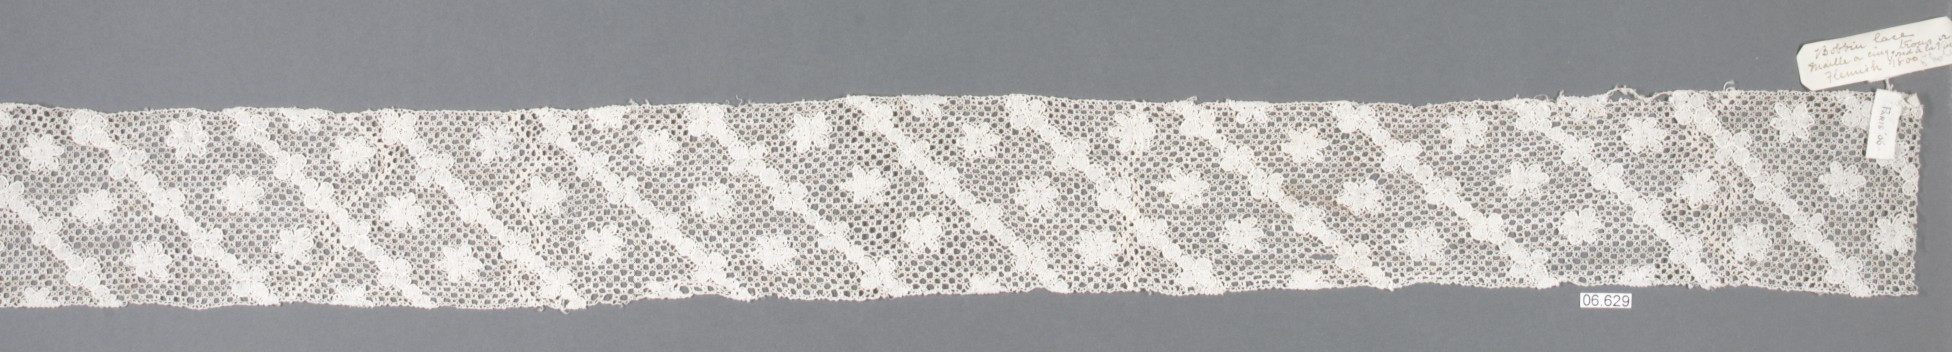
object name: insertion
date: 1800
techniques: lace